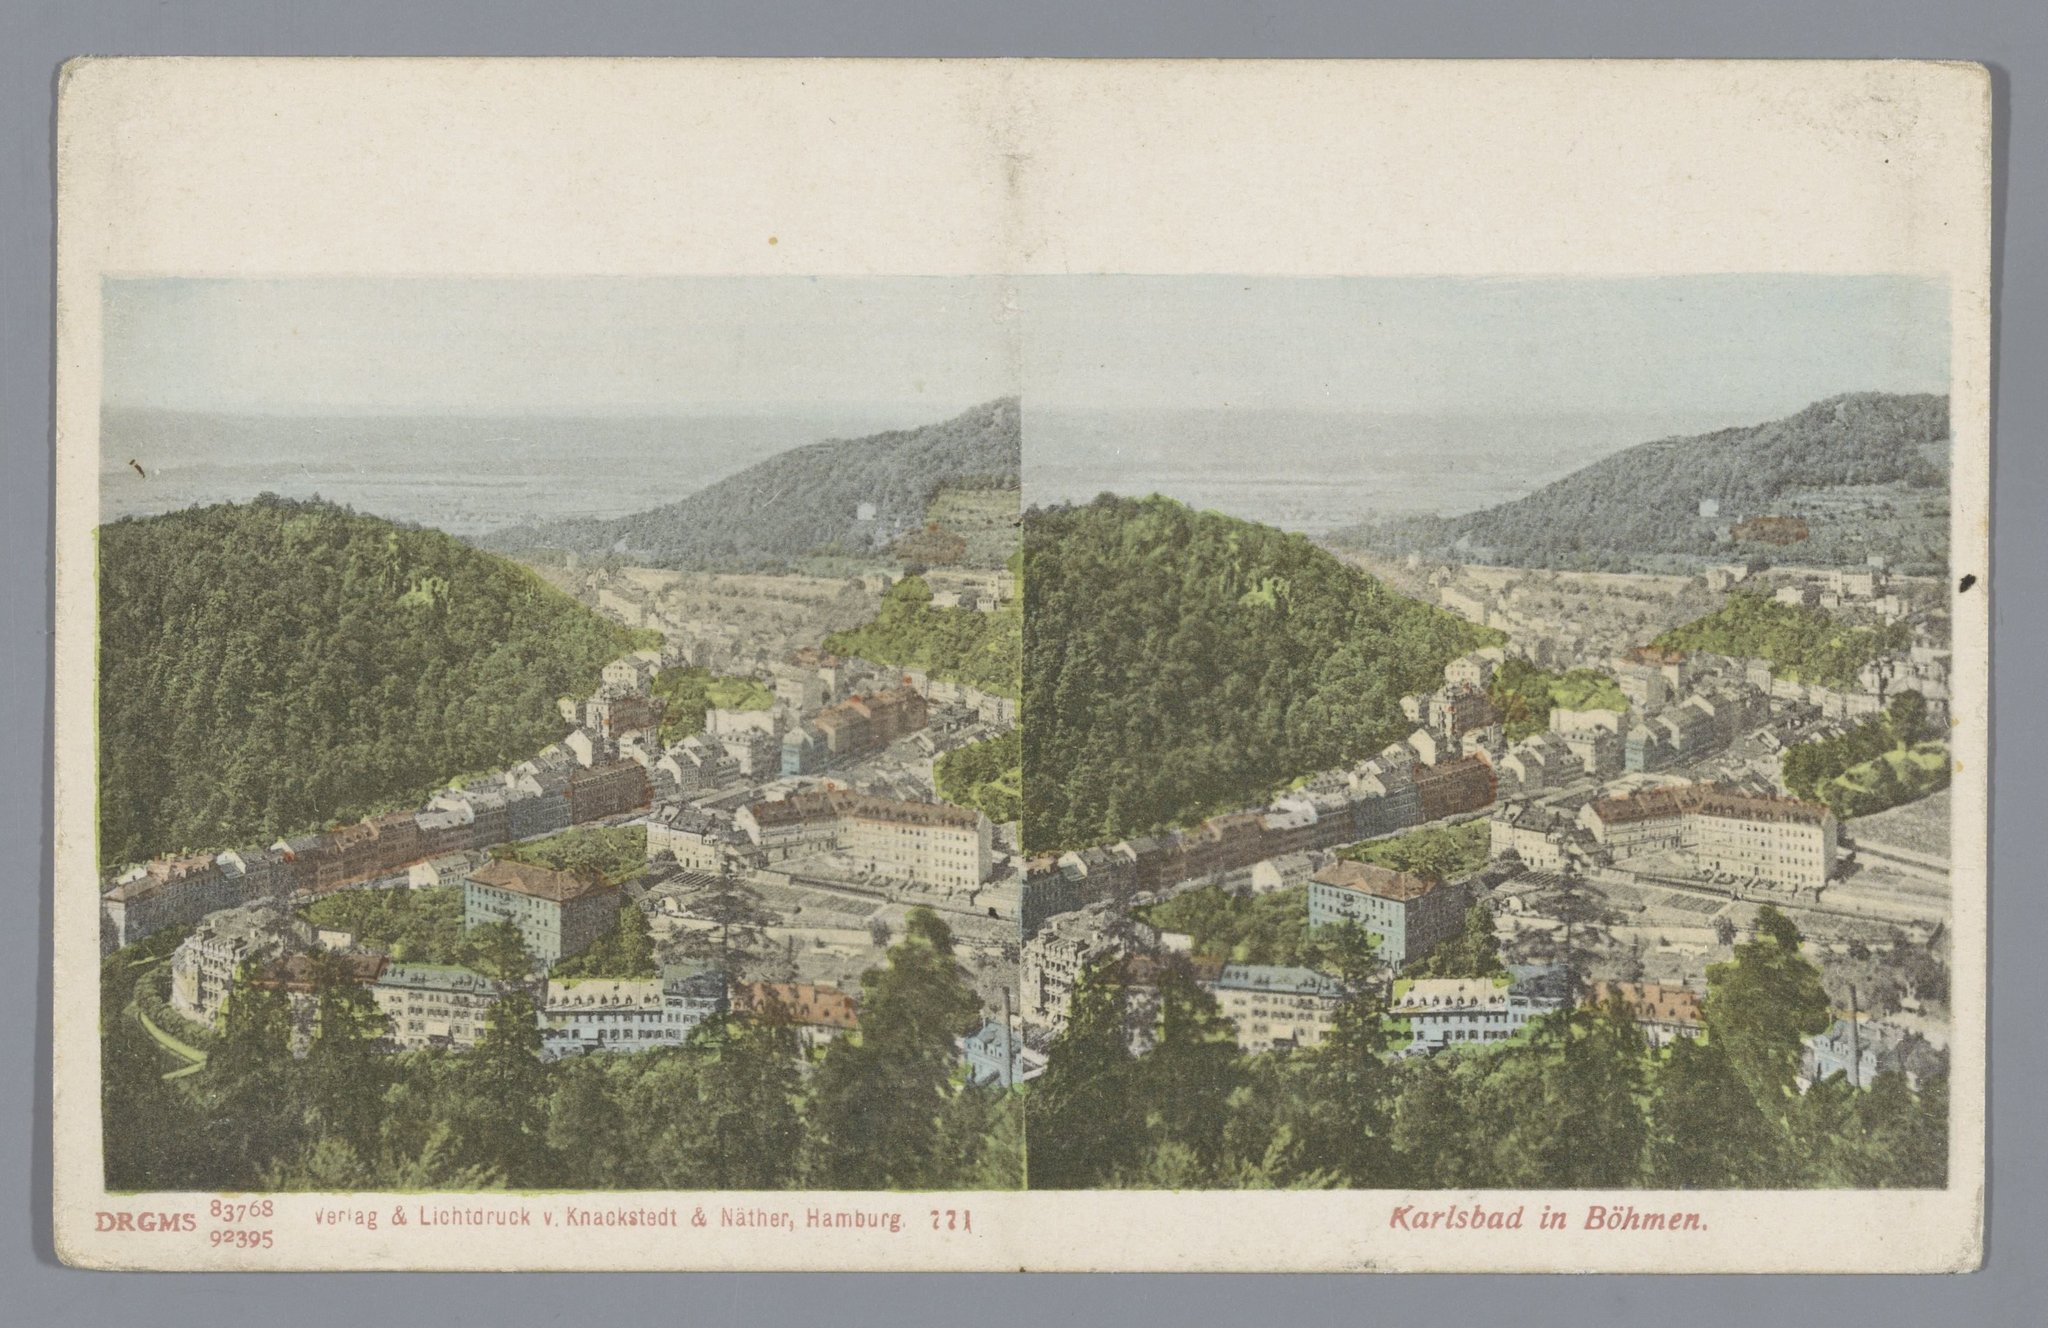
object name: ansichtkaart, prentbriefkaart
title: Karlsbad in Böhmen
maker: Anonymous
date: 1889-1905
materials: cardboard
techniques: photograph, hand coloring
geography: hamburg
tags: city-view in general; 'veduta'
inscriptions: inscription: ‘Post-Karte’, number: ‘771’, inscription: ‘DRGMS 83768/ 92395’